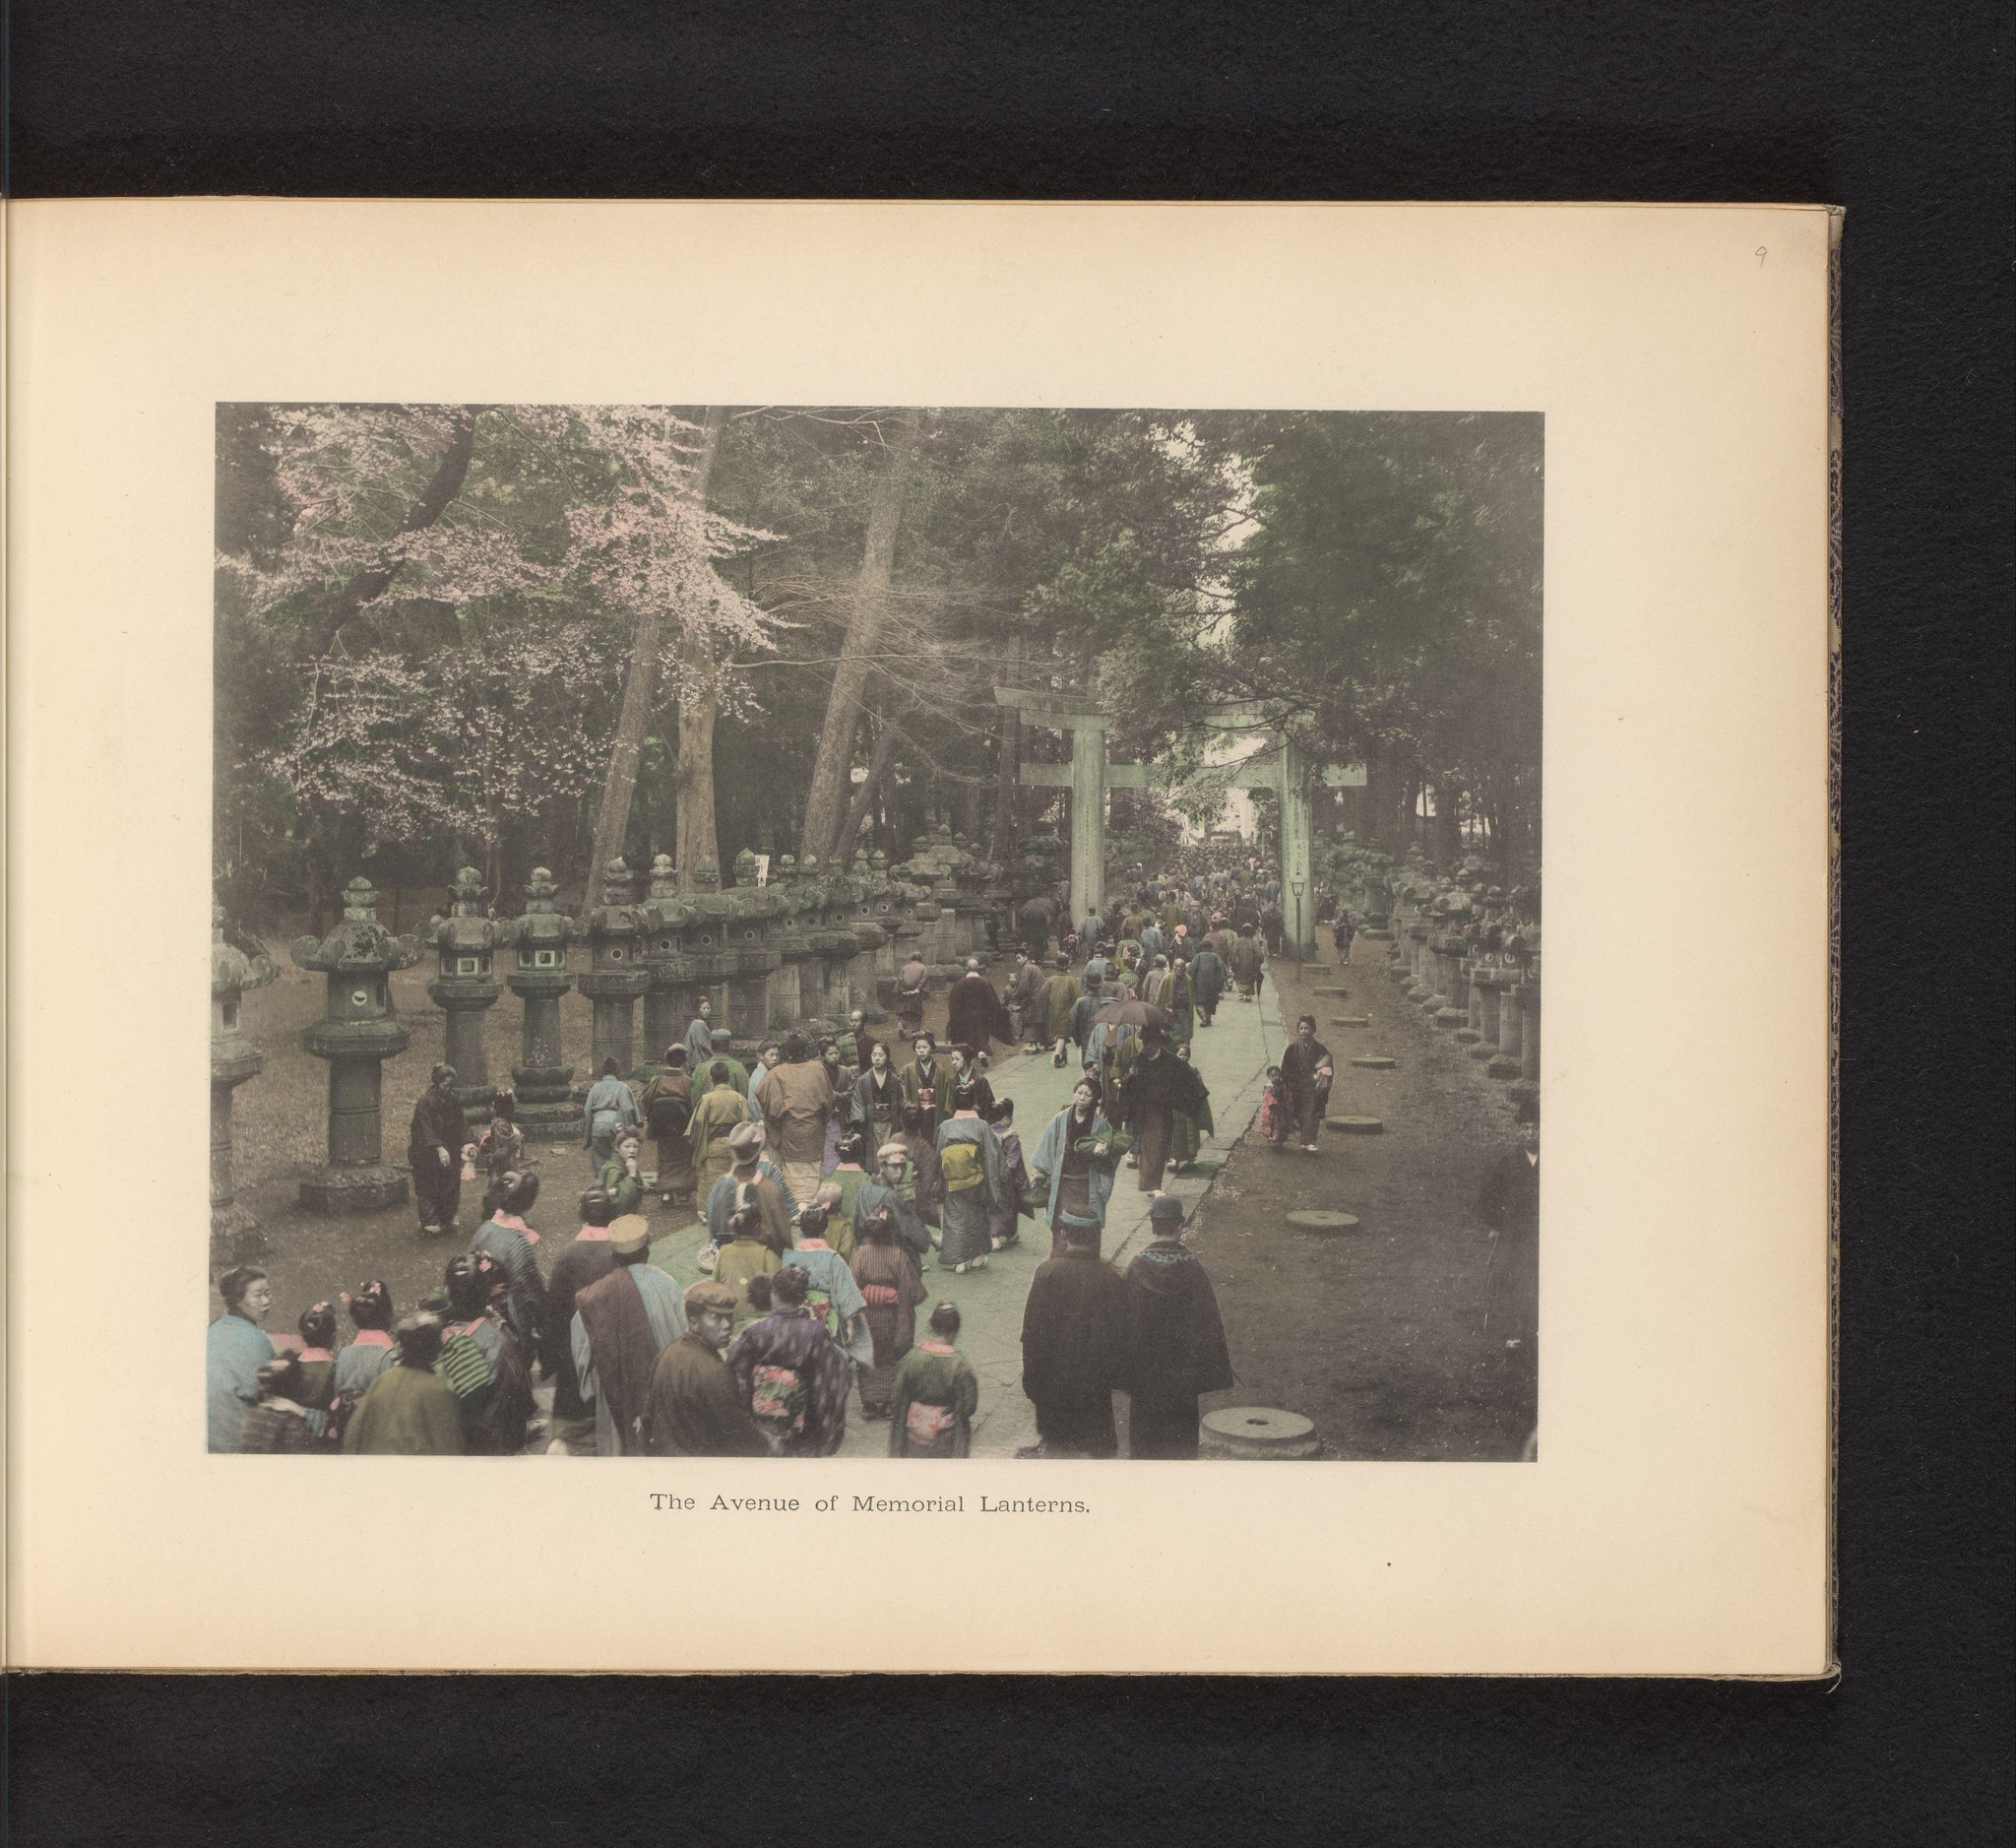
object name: photomechanical print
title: The Avenue of Memorial Lanterns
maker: kazumasa ogawa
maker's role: auteur, fotograaf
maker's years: 1860-1929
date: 1892-1897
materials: paper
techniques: photograph, hand coloring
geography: uenopark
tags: park, road, path, lantern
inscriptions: number: ‘9’